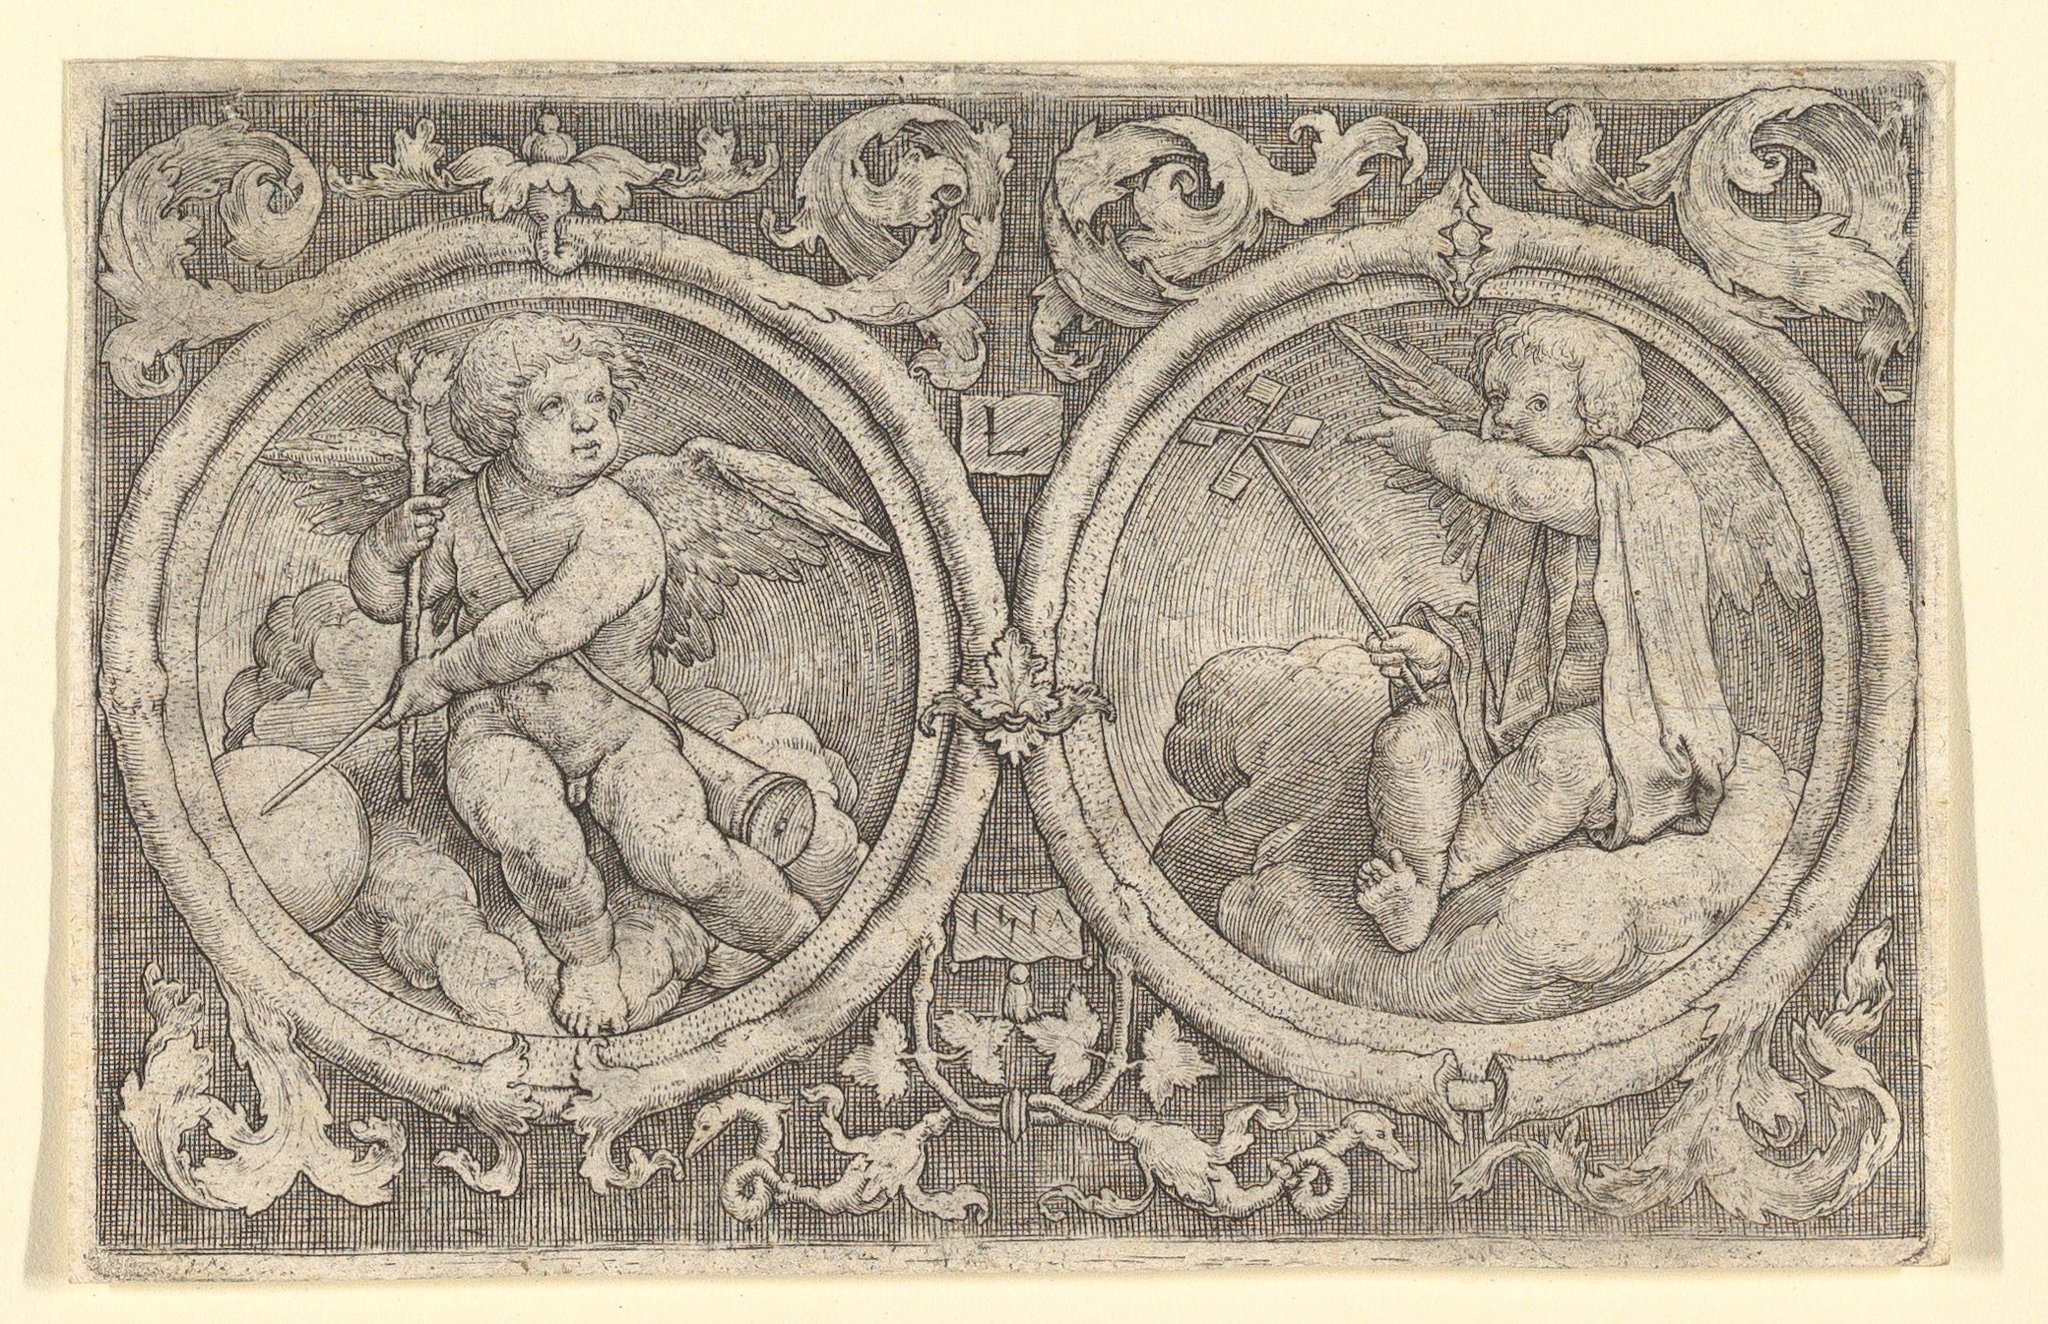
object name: print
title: Two Putti Seated in Clouds in Circles with Tendrils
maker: lucas van leyden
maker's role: artist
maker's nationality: netherlandish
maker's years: 1494-1533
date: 1517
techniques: engraving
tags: putti